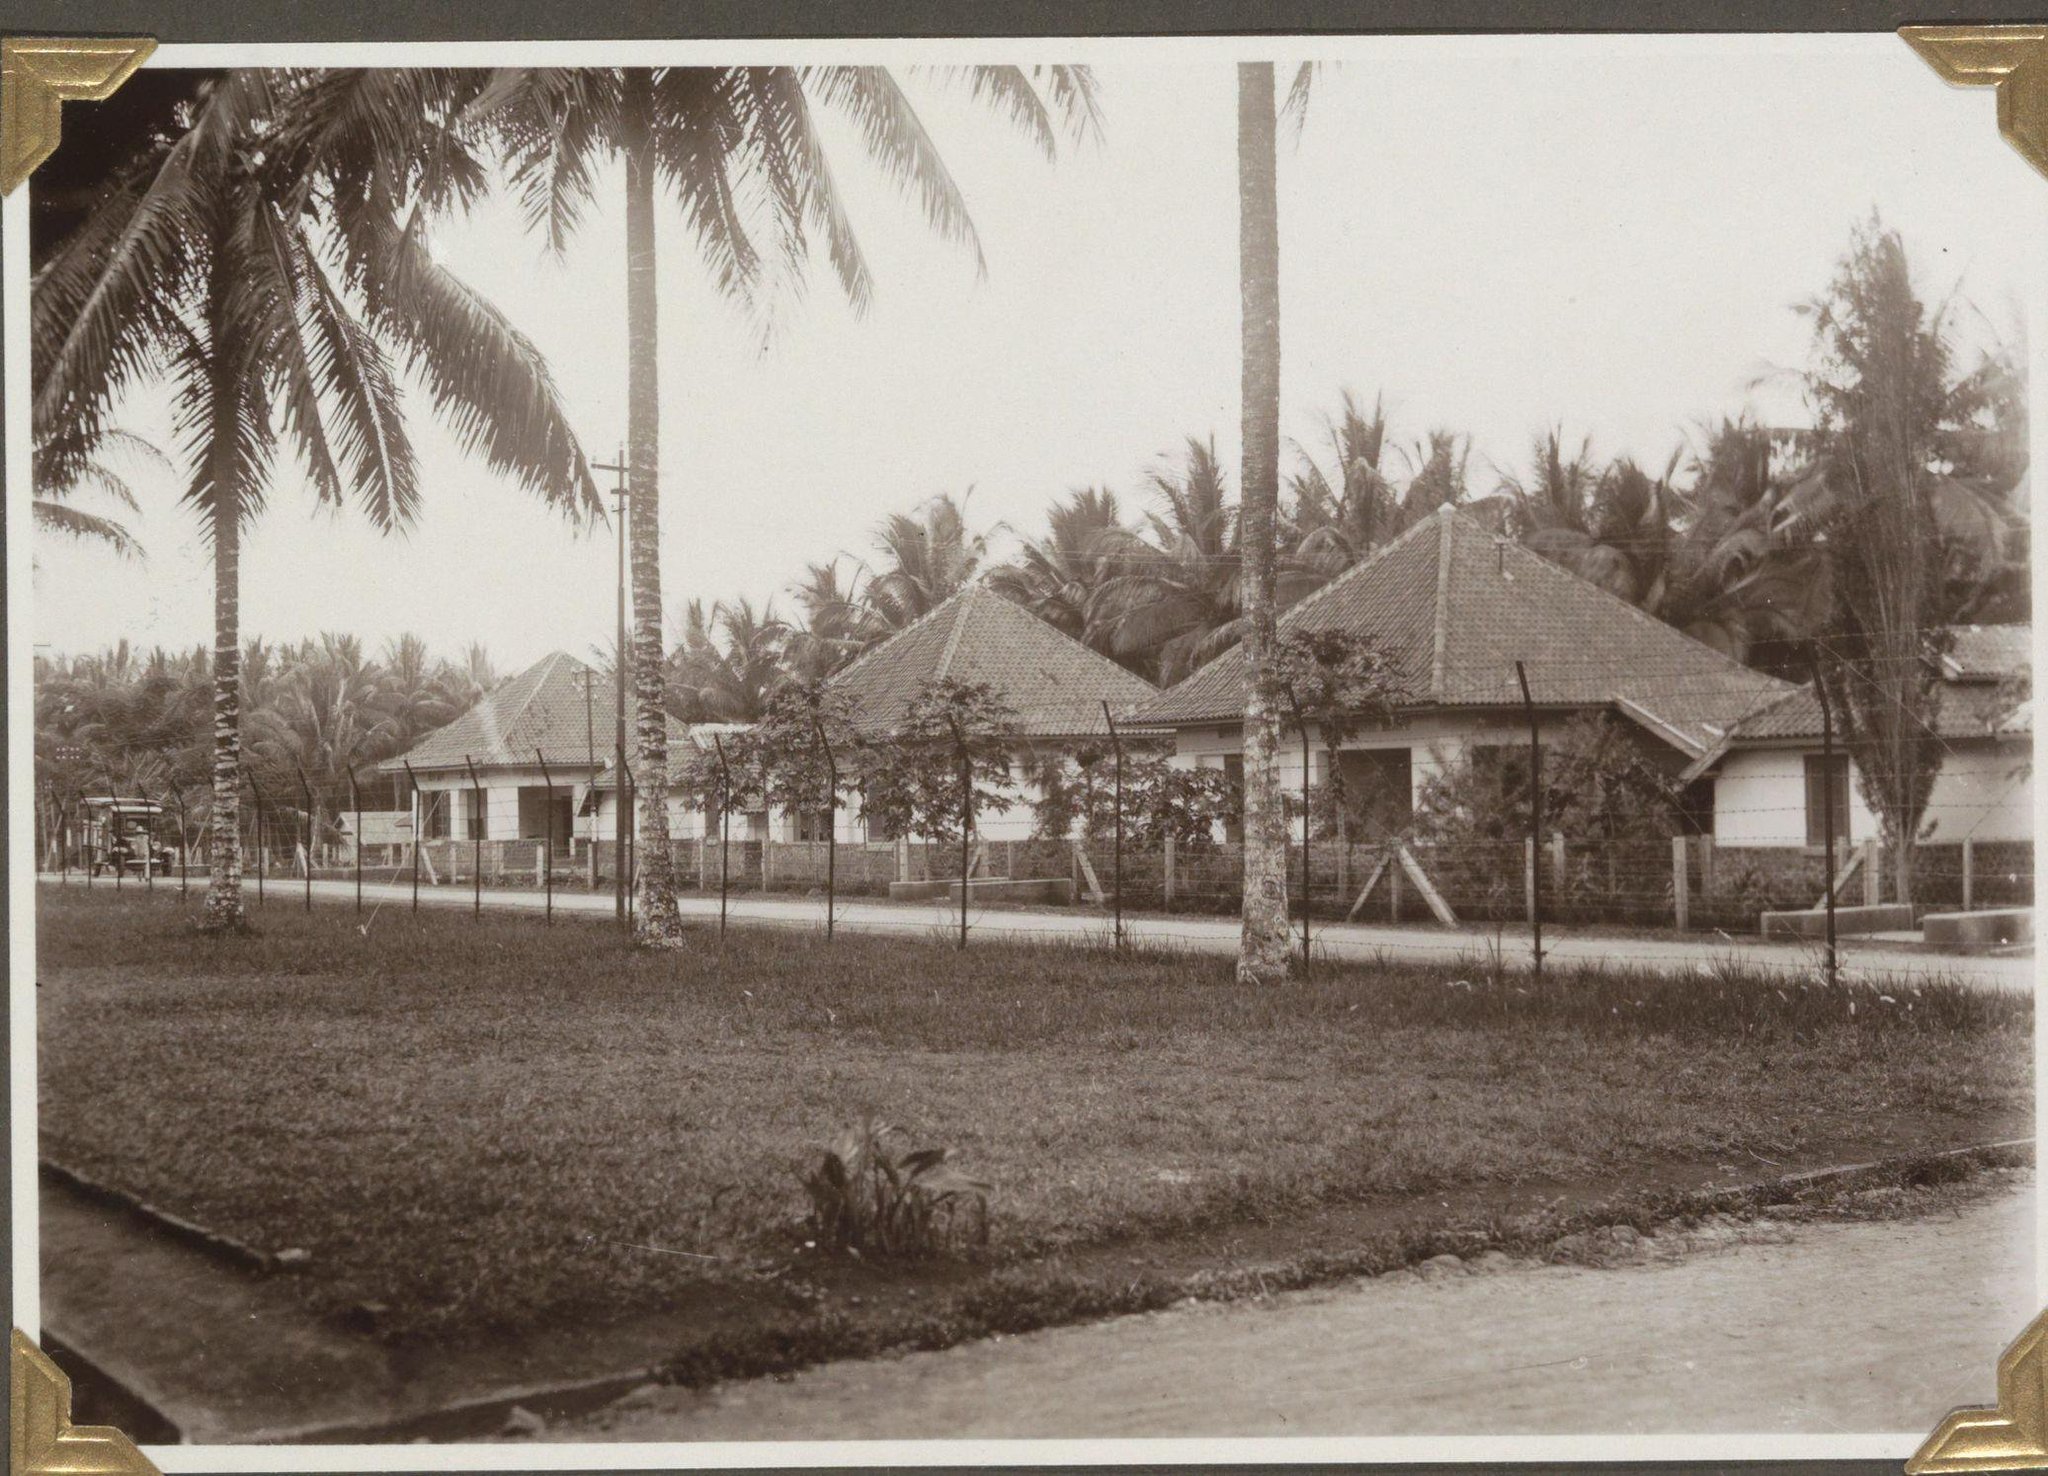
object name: photograph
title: Dienstwoningen van het Europeesch Personeel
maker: Anonymous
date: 1932-1933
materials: photographic support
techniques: gelatin silver print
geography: lampung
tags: rural housing, e.g. country-house, villa, cottage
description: Onderdeel van Herinneringsalbum voor F.J. Junius, vertrekkend resident van Lampong (Zuid-Sumatra).